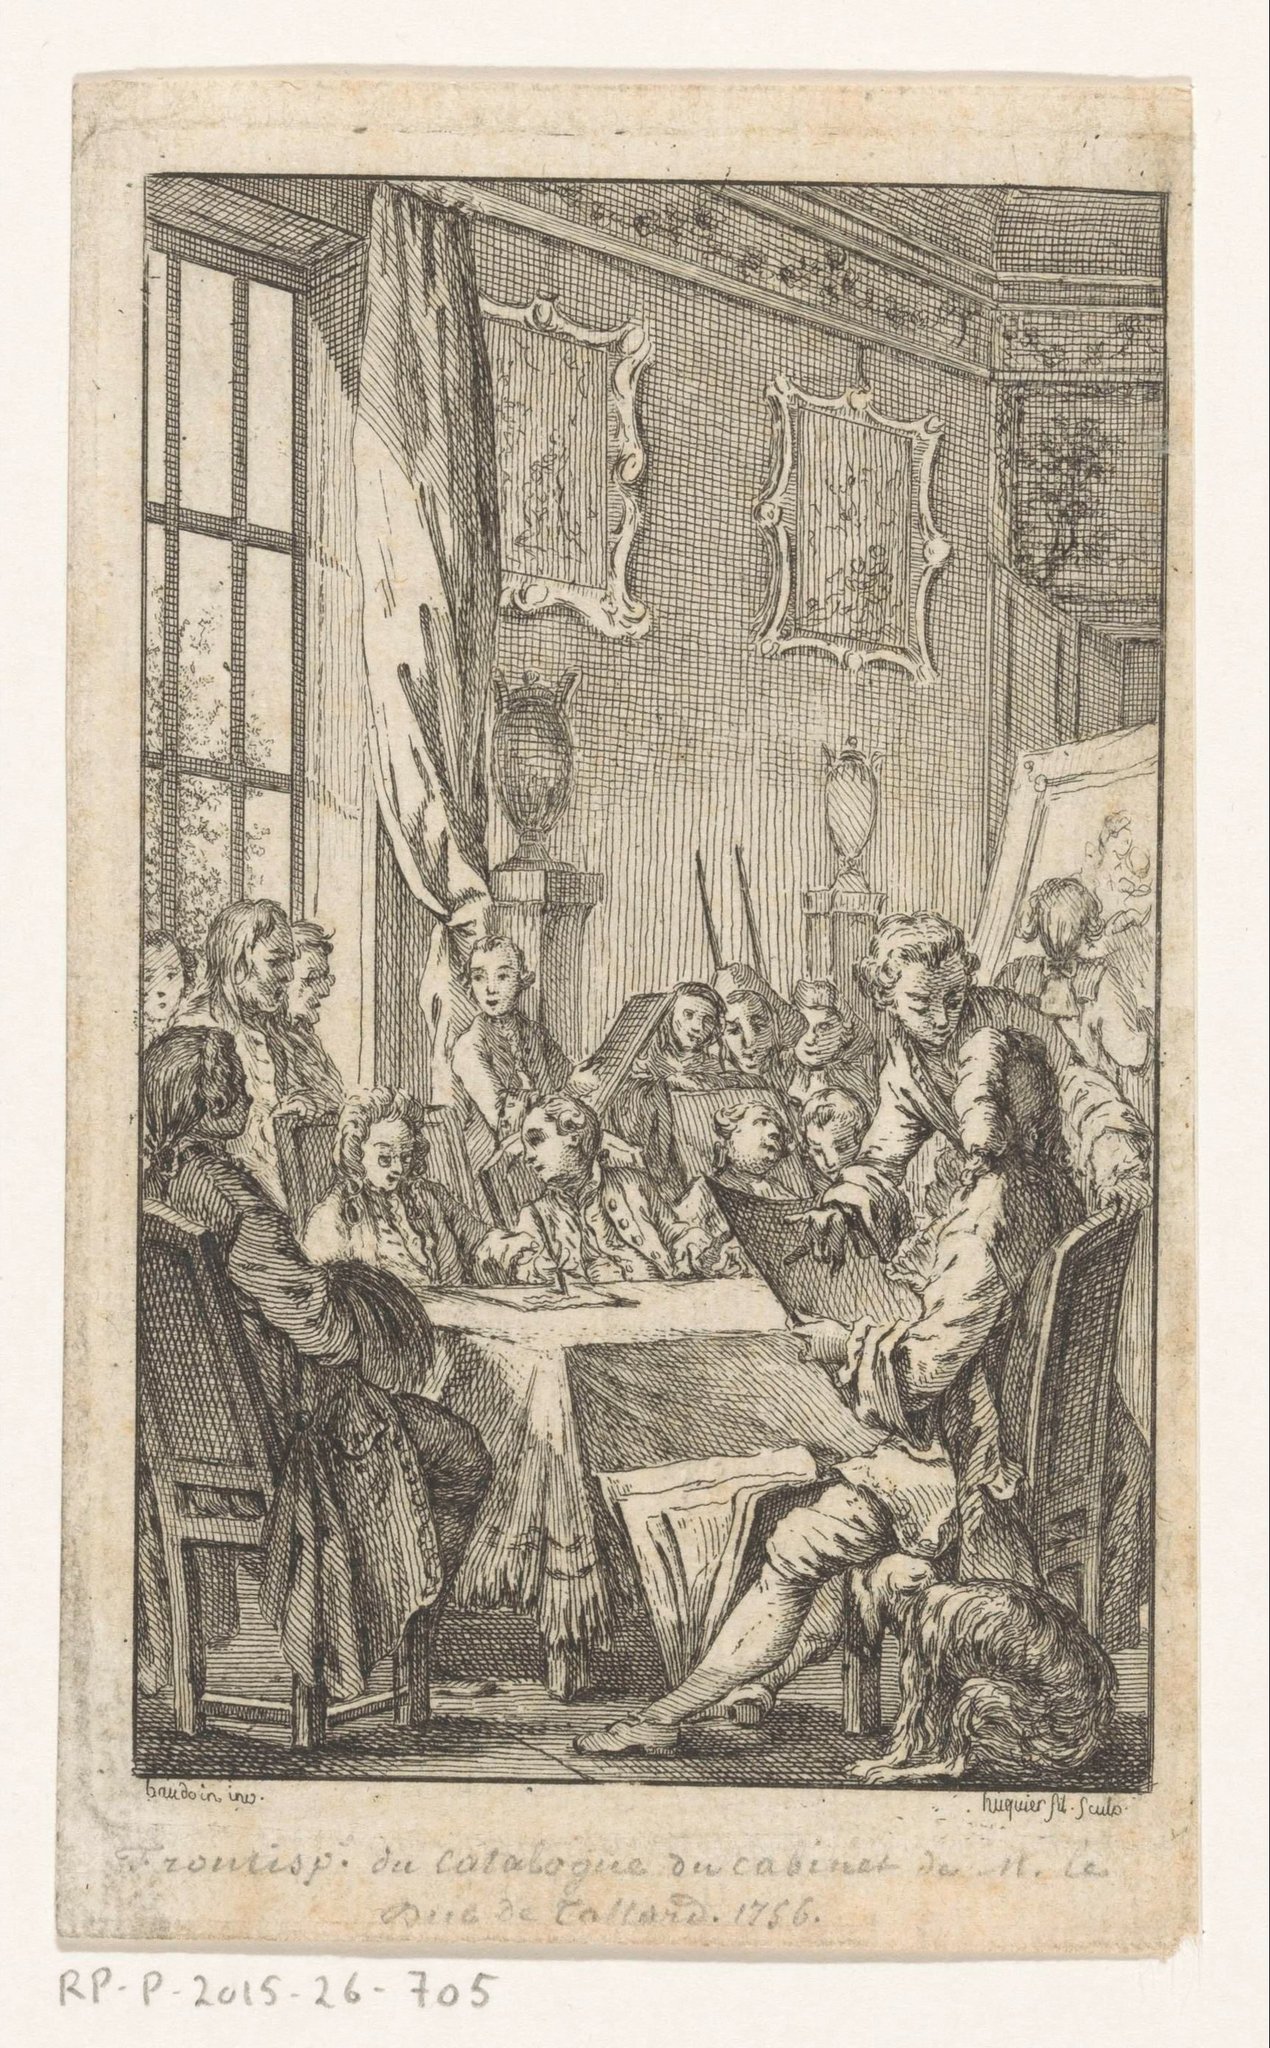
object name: print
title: Titelpagina voor: Pierre Rémy, Catalogus raisonné des tableaux, sculptures (...) qui composent le Cabinet de feu Monsieur le Duc de Tallard, 1756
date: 1756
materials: paper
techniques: etching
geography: paris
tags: art collecting, art sale, auction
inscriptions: collector's mark: Lugt 2228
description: Prent gebruikt als titelpagina voor: Rémy, Pierre en Glomy, Jean-Baptiste. Catalogus raisonné des tableaux, sculptures ... qui composent le Cabinet de feu Monsieur le Duc de Tallard. Parijs: Didot, 1756.